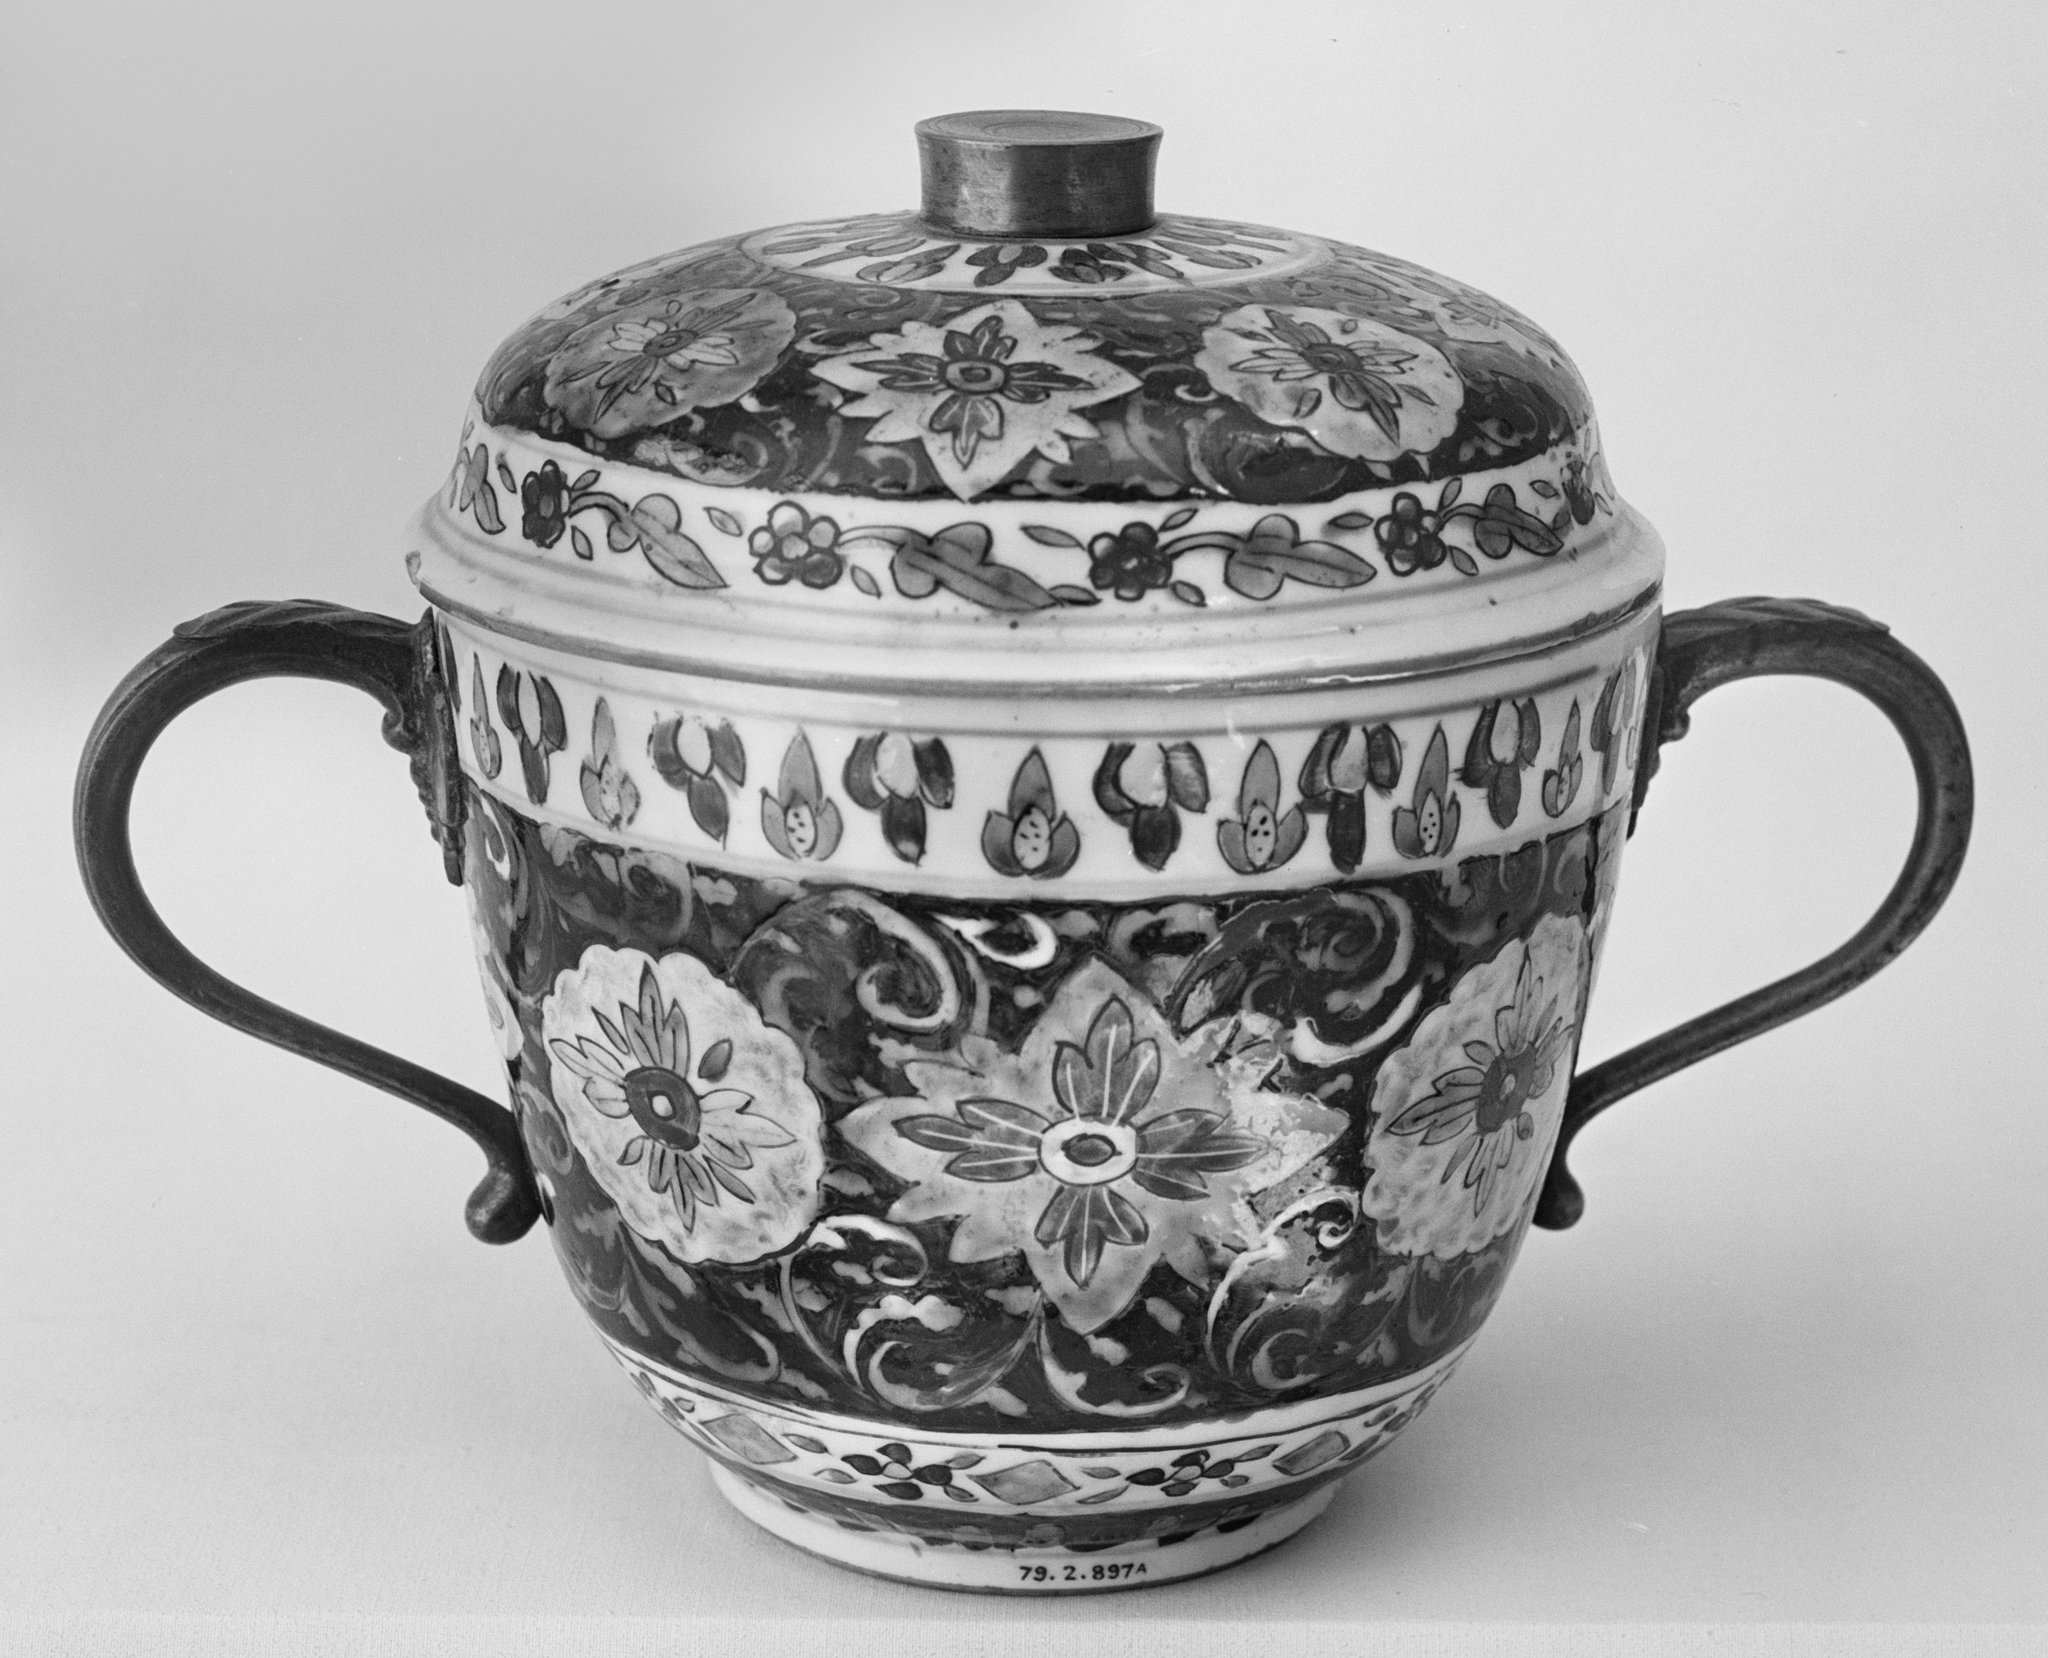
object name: covered bowl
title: Covered bowl with floral pattern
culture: chinese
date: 1767-1833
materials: cobalt, enamel, porcelain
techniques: painting, underglaze